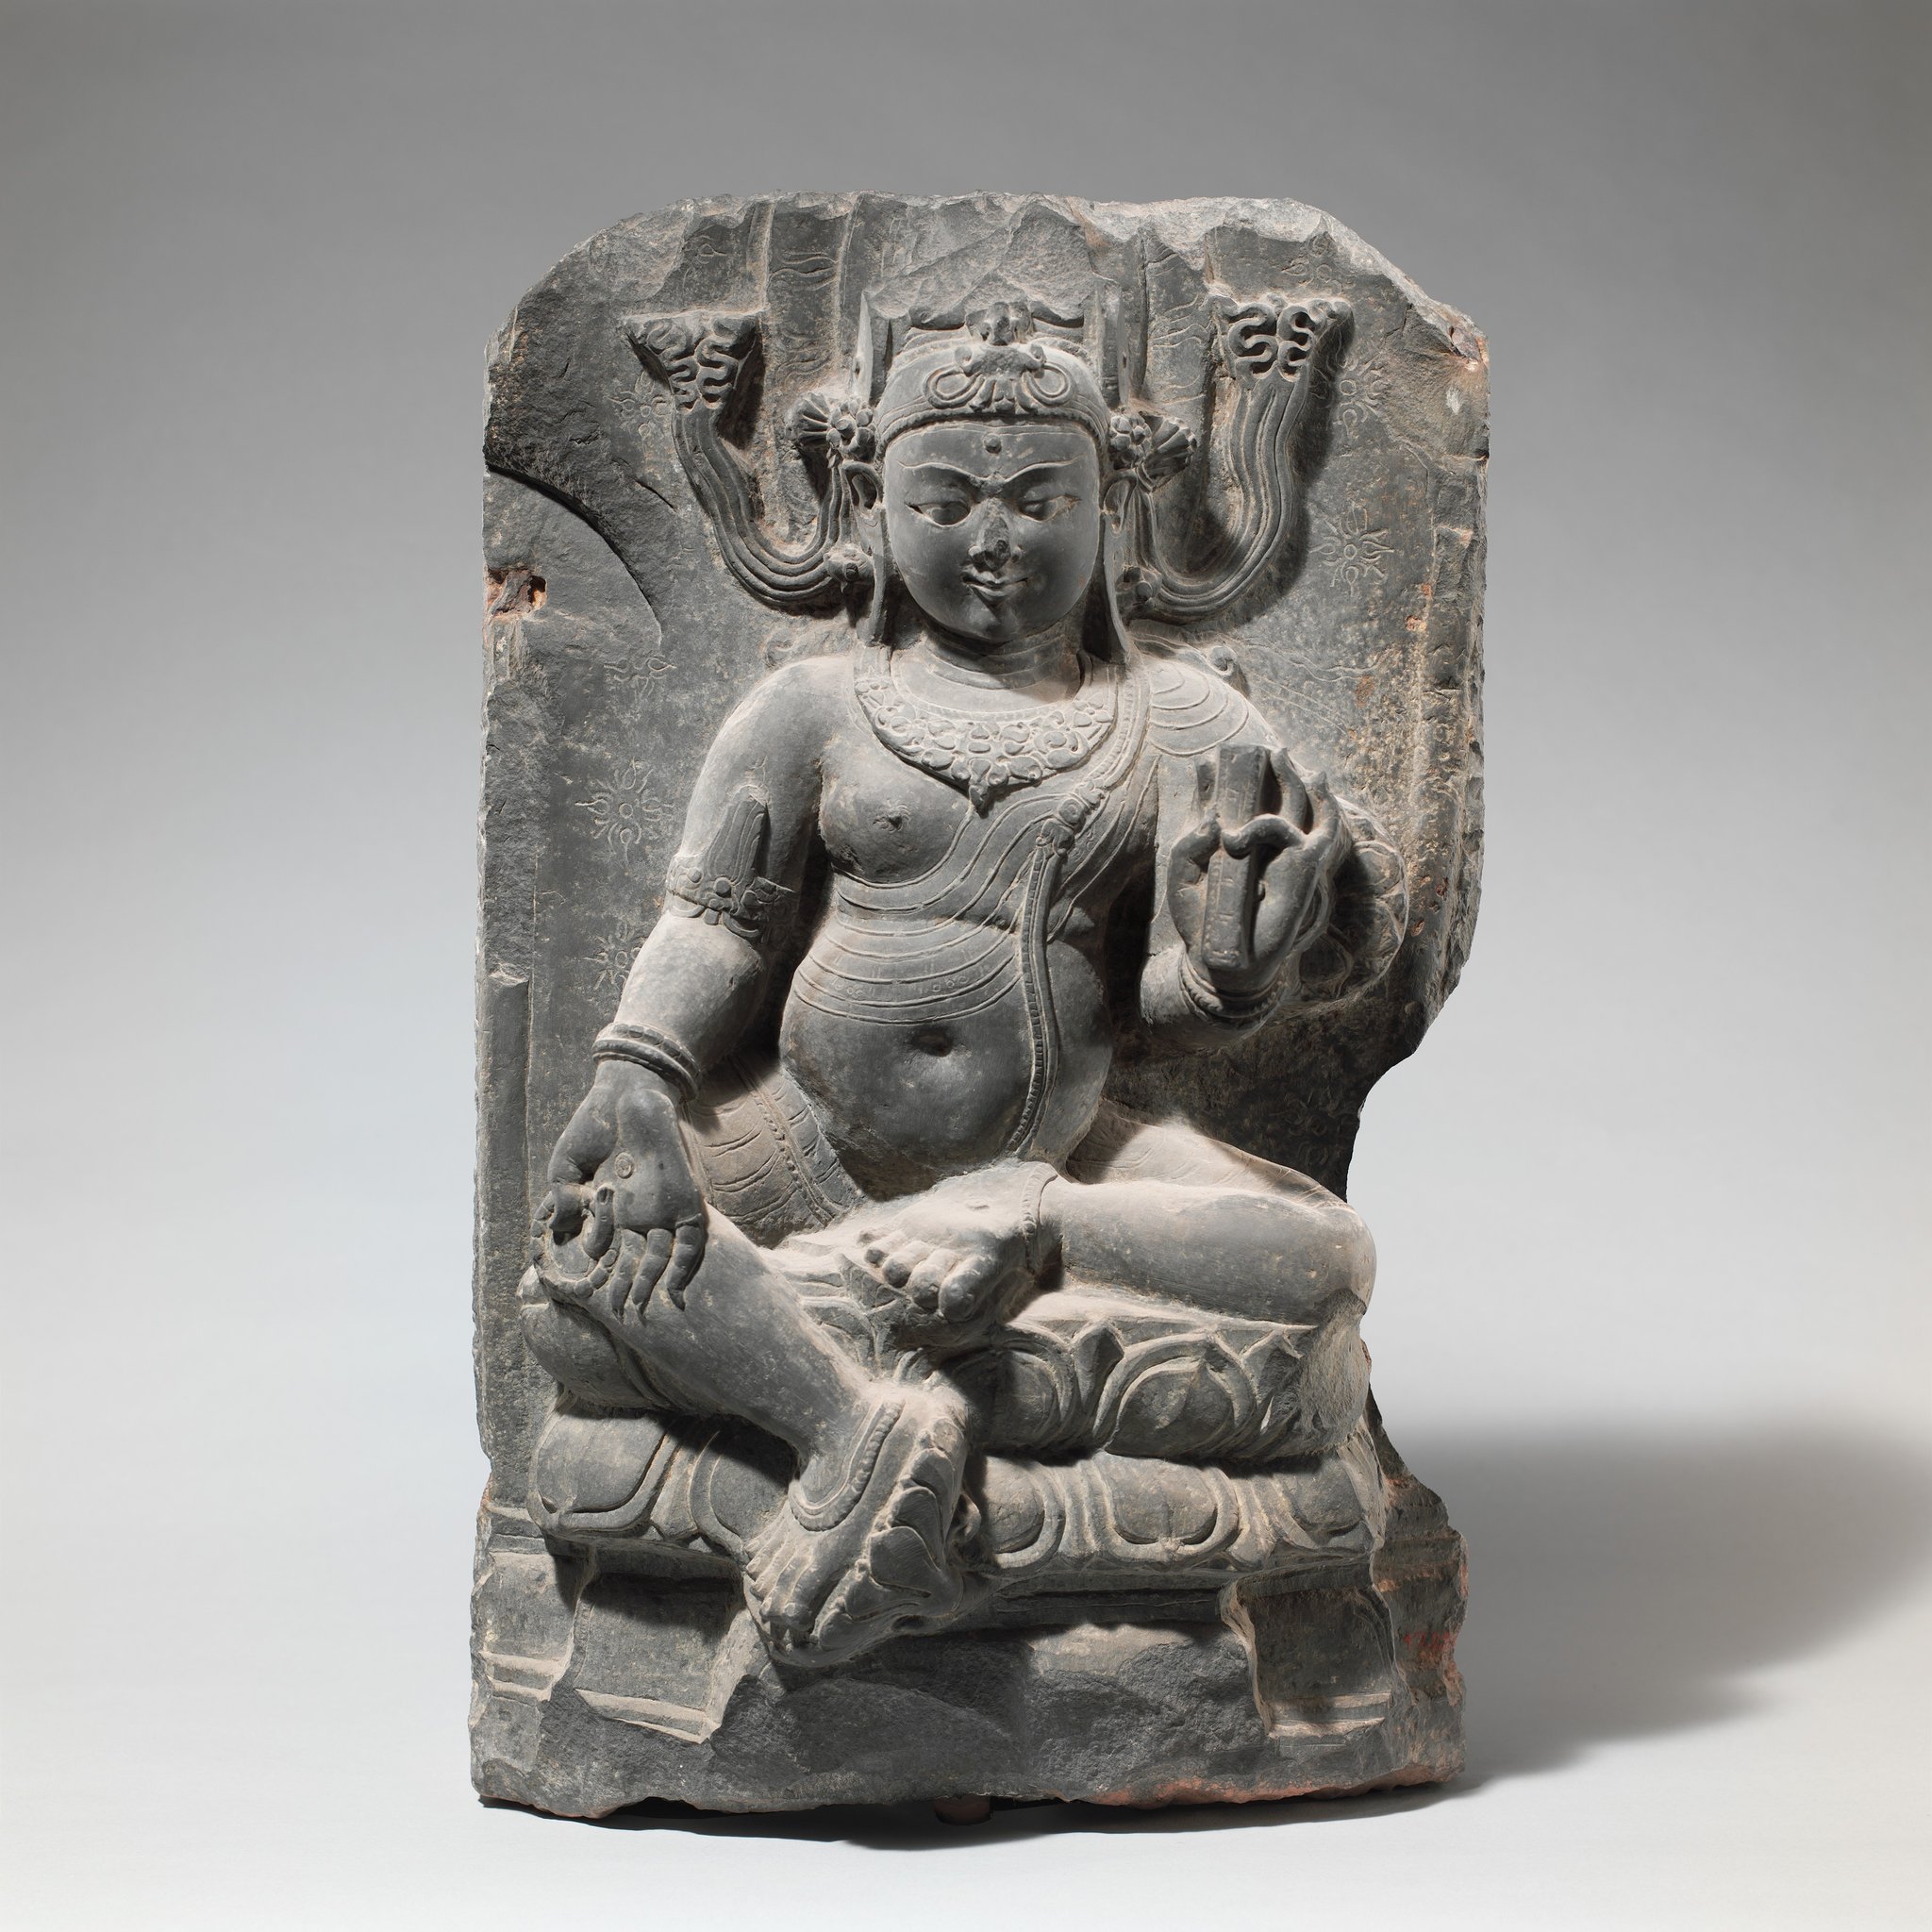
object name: relief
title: Brhaspati (The Personification of the Planet Jupiter)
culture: indian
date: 1101-1200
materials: stone